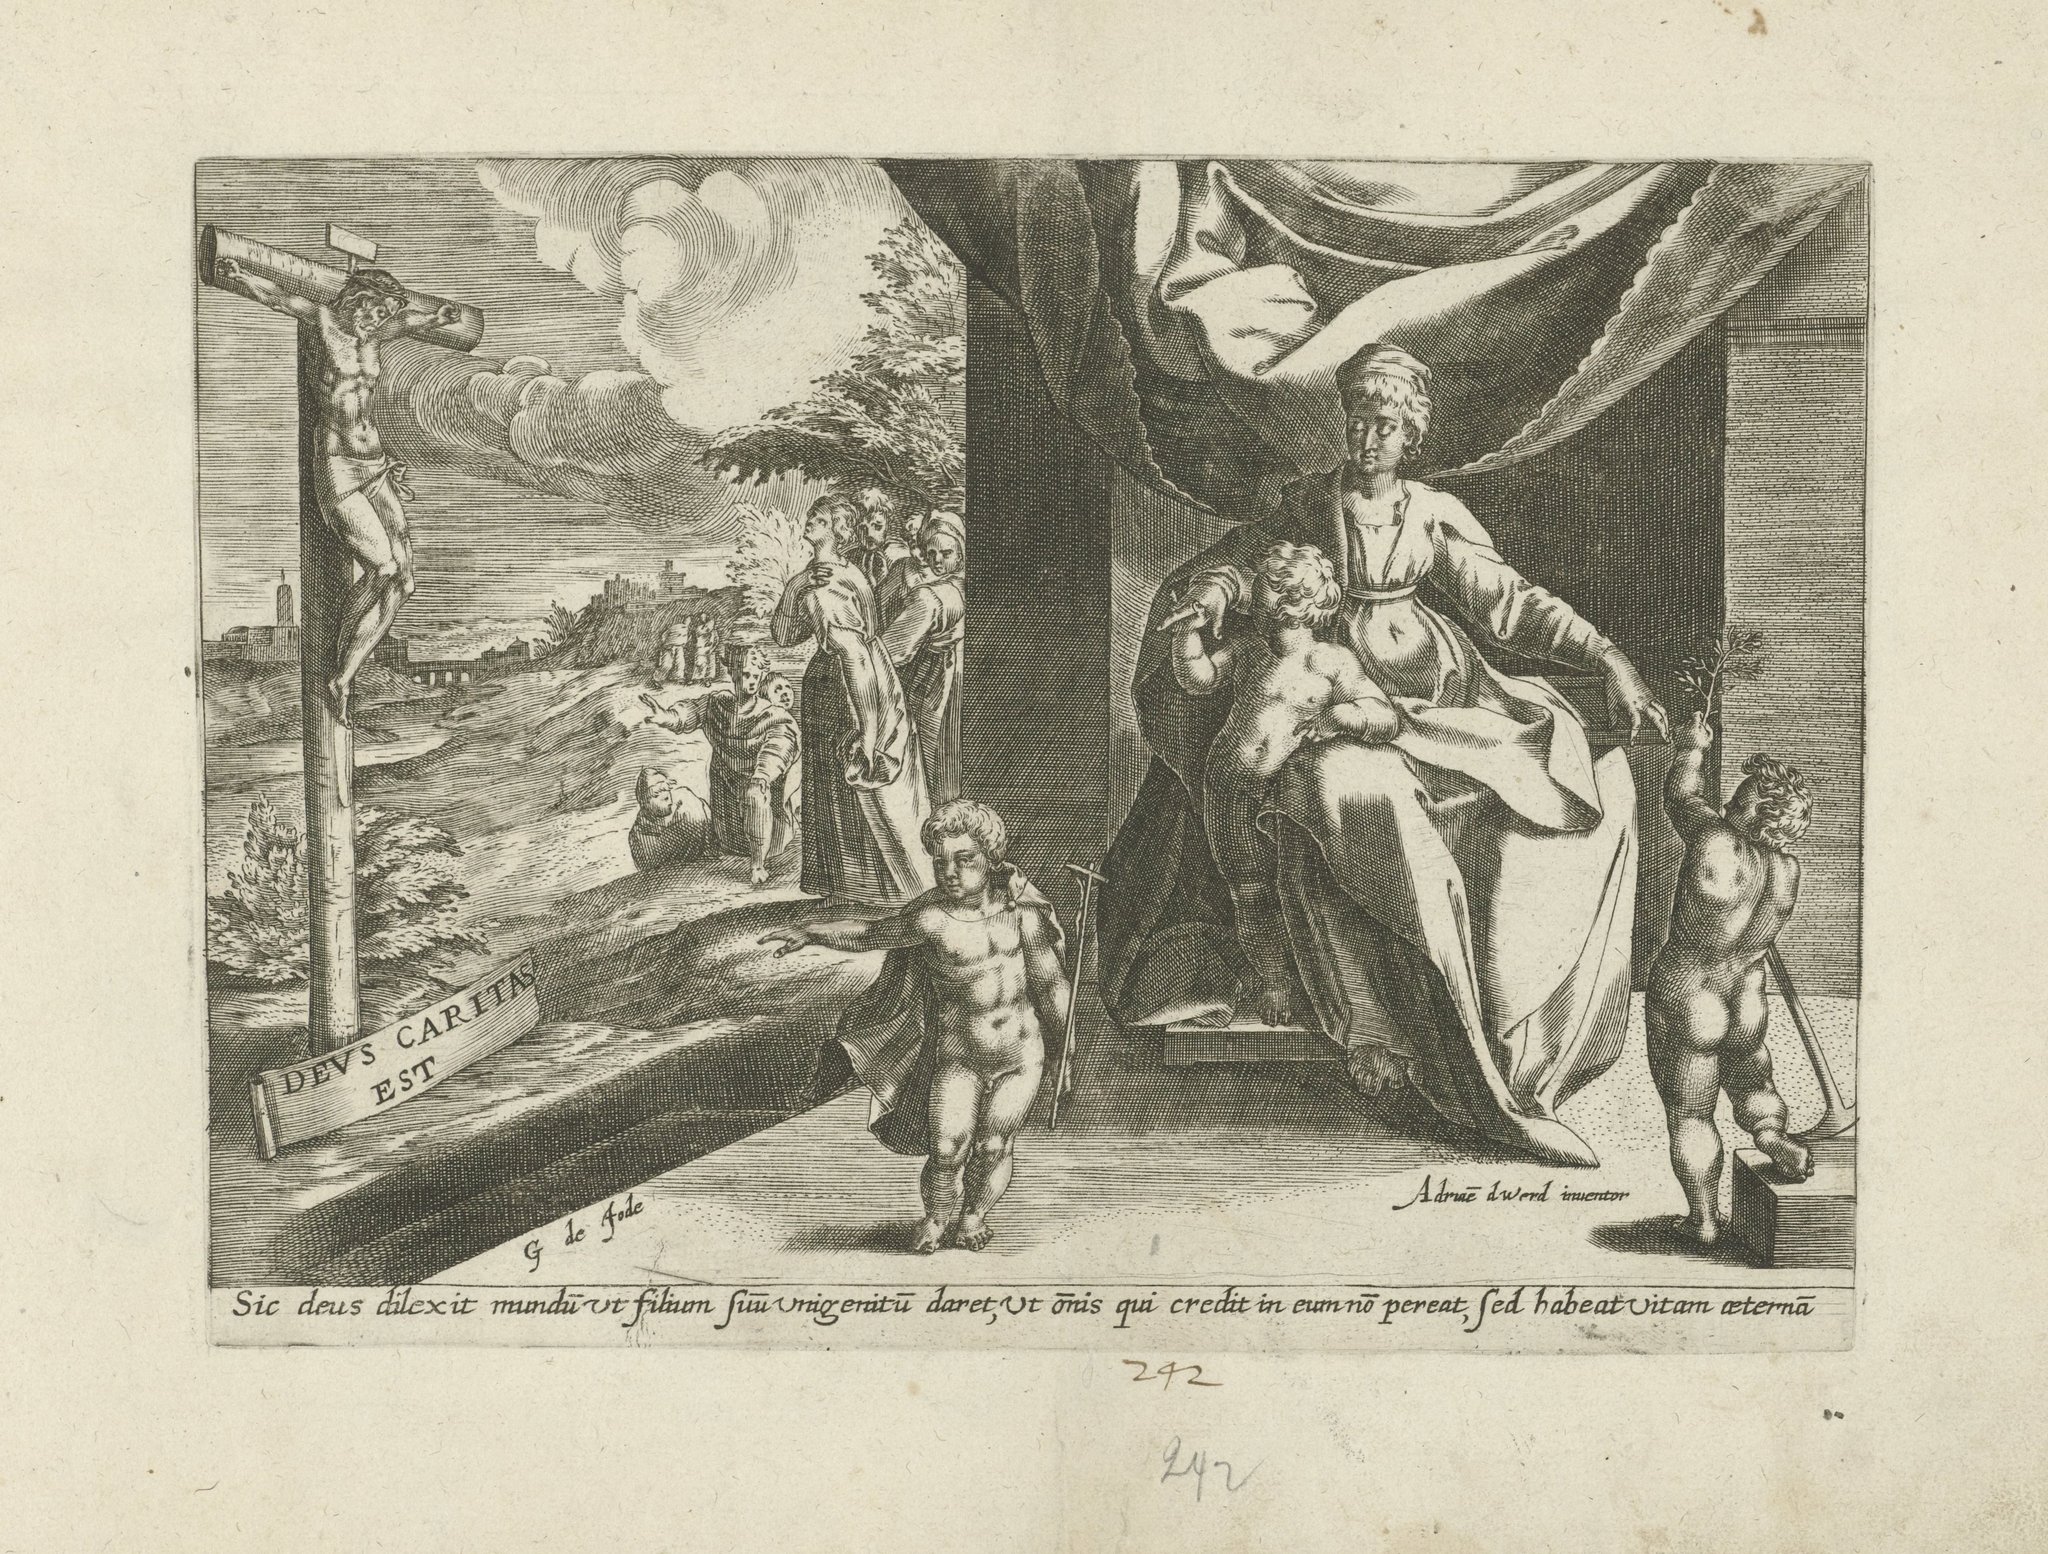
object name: print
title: Personificatie van Caritas en Christus aan het kruis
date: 1547-1591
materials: paper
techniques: engraving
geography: antwerp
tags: charity, 'caritas'; 'carità' (ripa) ~ one of the three theological virtues, representations of christ's death on the cross, with a particular event or saying of christ emphasized (up to christ's death) - dd - only christ on the cross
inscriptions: inscription: ‘242’, collector's mark: Lugt 2760, collector's mark: Lugt 2228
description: Op de voorgrond zit Caritas, de personificatie van liefde, naast haar een kind. Rechts voor haar staat een kind met anker en een tak in de hand: de personificatie van hoop. Links voor haar staat een kind met een kruis in de hand, de personificatie van geloof, wijzend naar Christus aan het kruis. Op de achtergrond een landschap met een groep toeschouwers die naar de gekruisigde Christus kijken. Onder het kruis de tekst God is liefde in het Latijn. Onder de voorstelling de Bijbeltekst uit Joh. 3:16 in het Latijn.